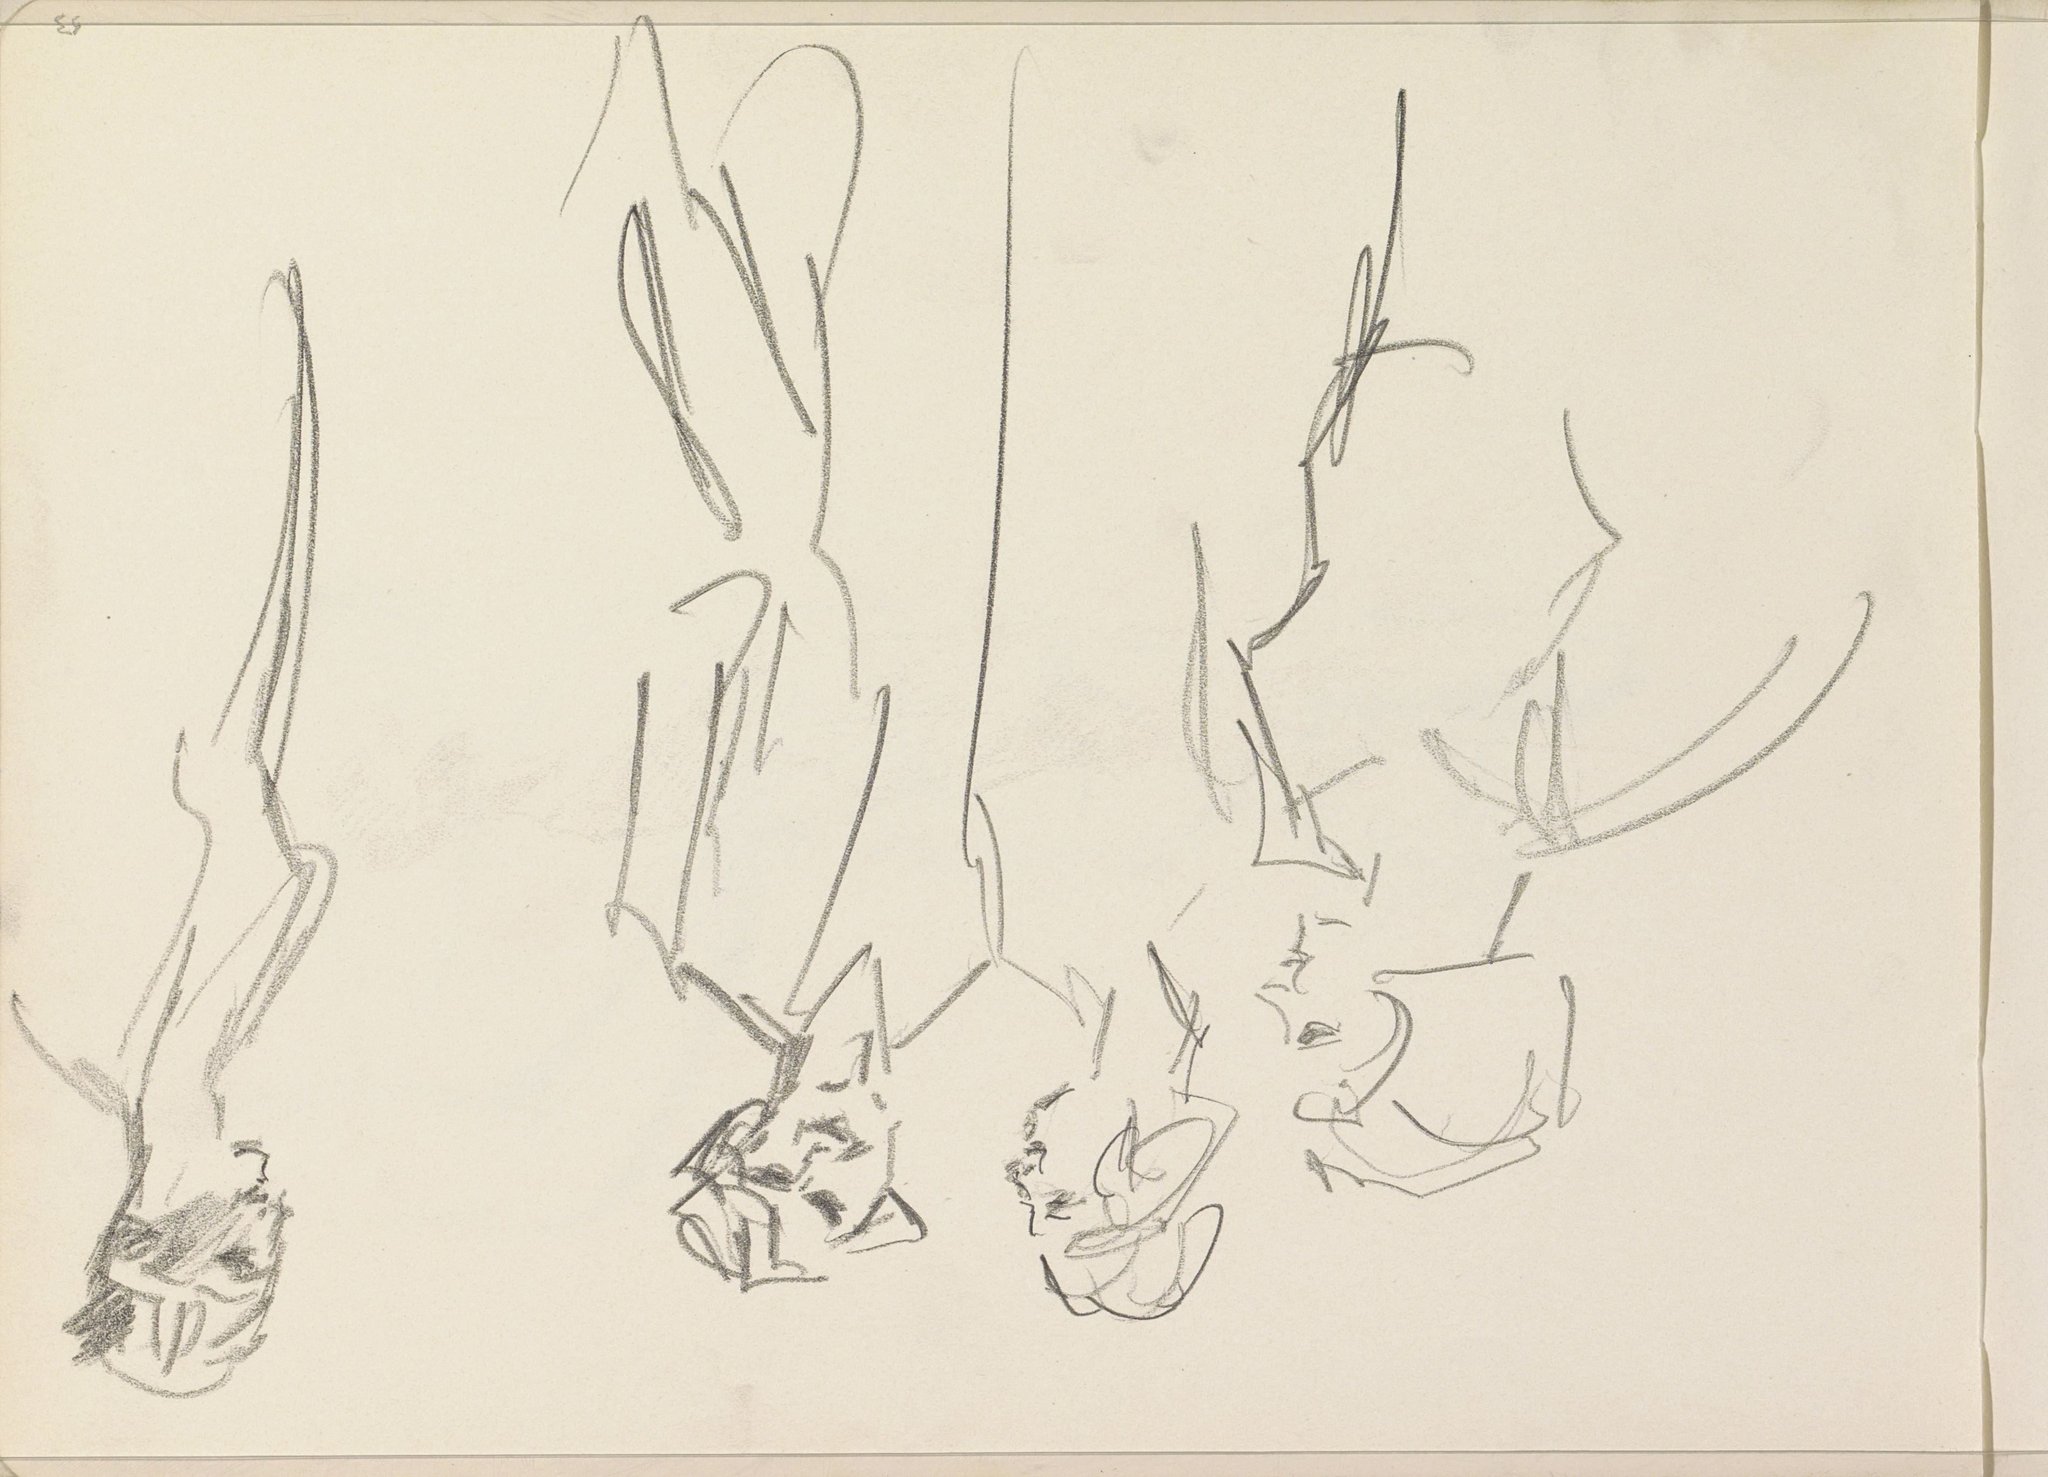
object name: sketchbook leaf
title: Vier staande vrouwen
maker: isaac israels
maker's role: draughtsman, painter, print maker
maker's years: 1865-1934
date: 1875-1934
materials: paper, pencil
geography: the hague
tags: standing figure - aa - female human figure (+ four persons)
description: Blad 14 verso uit schetsboek V met 33 bladen.